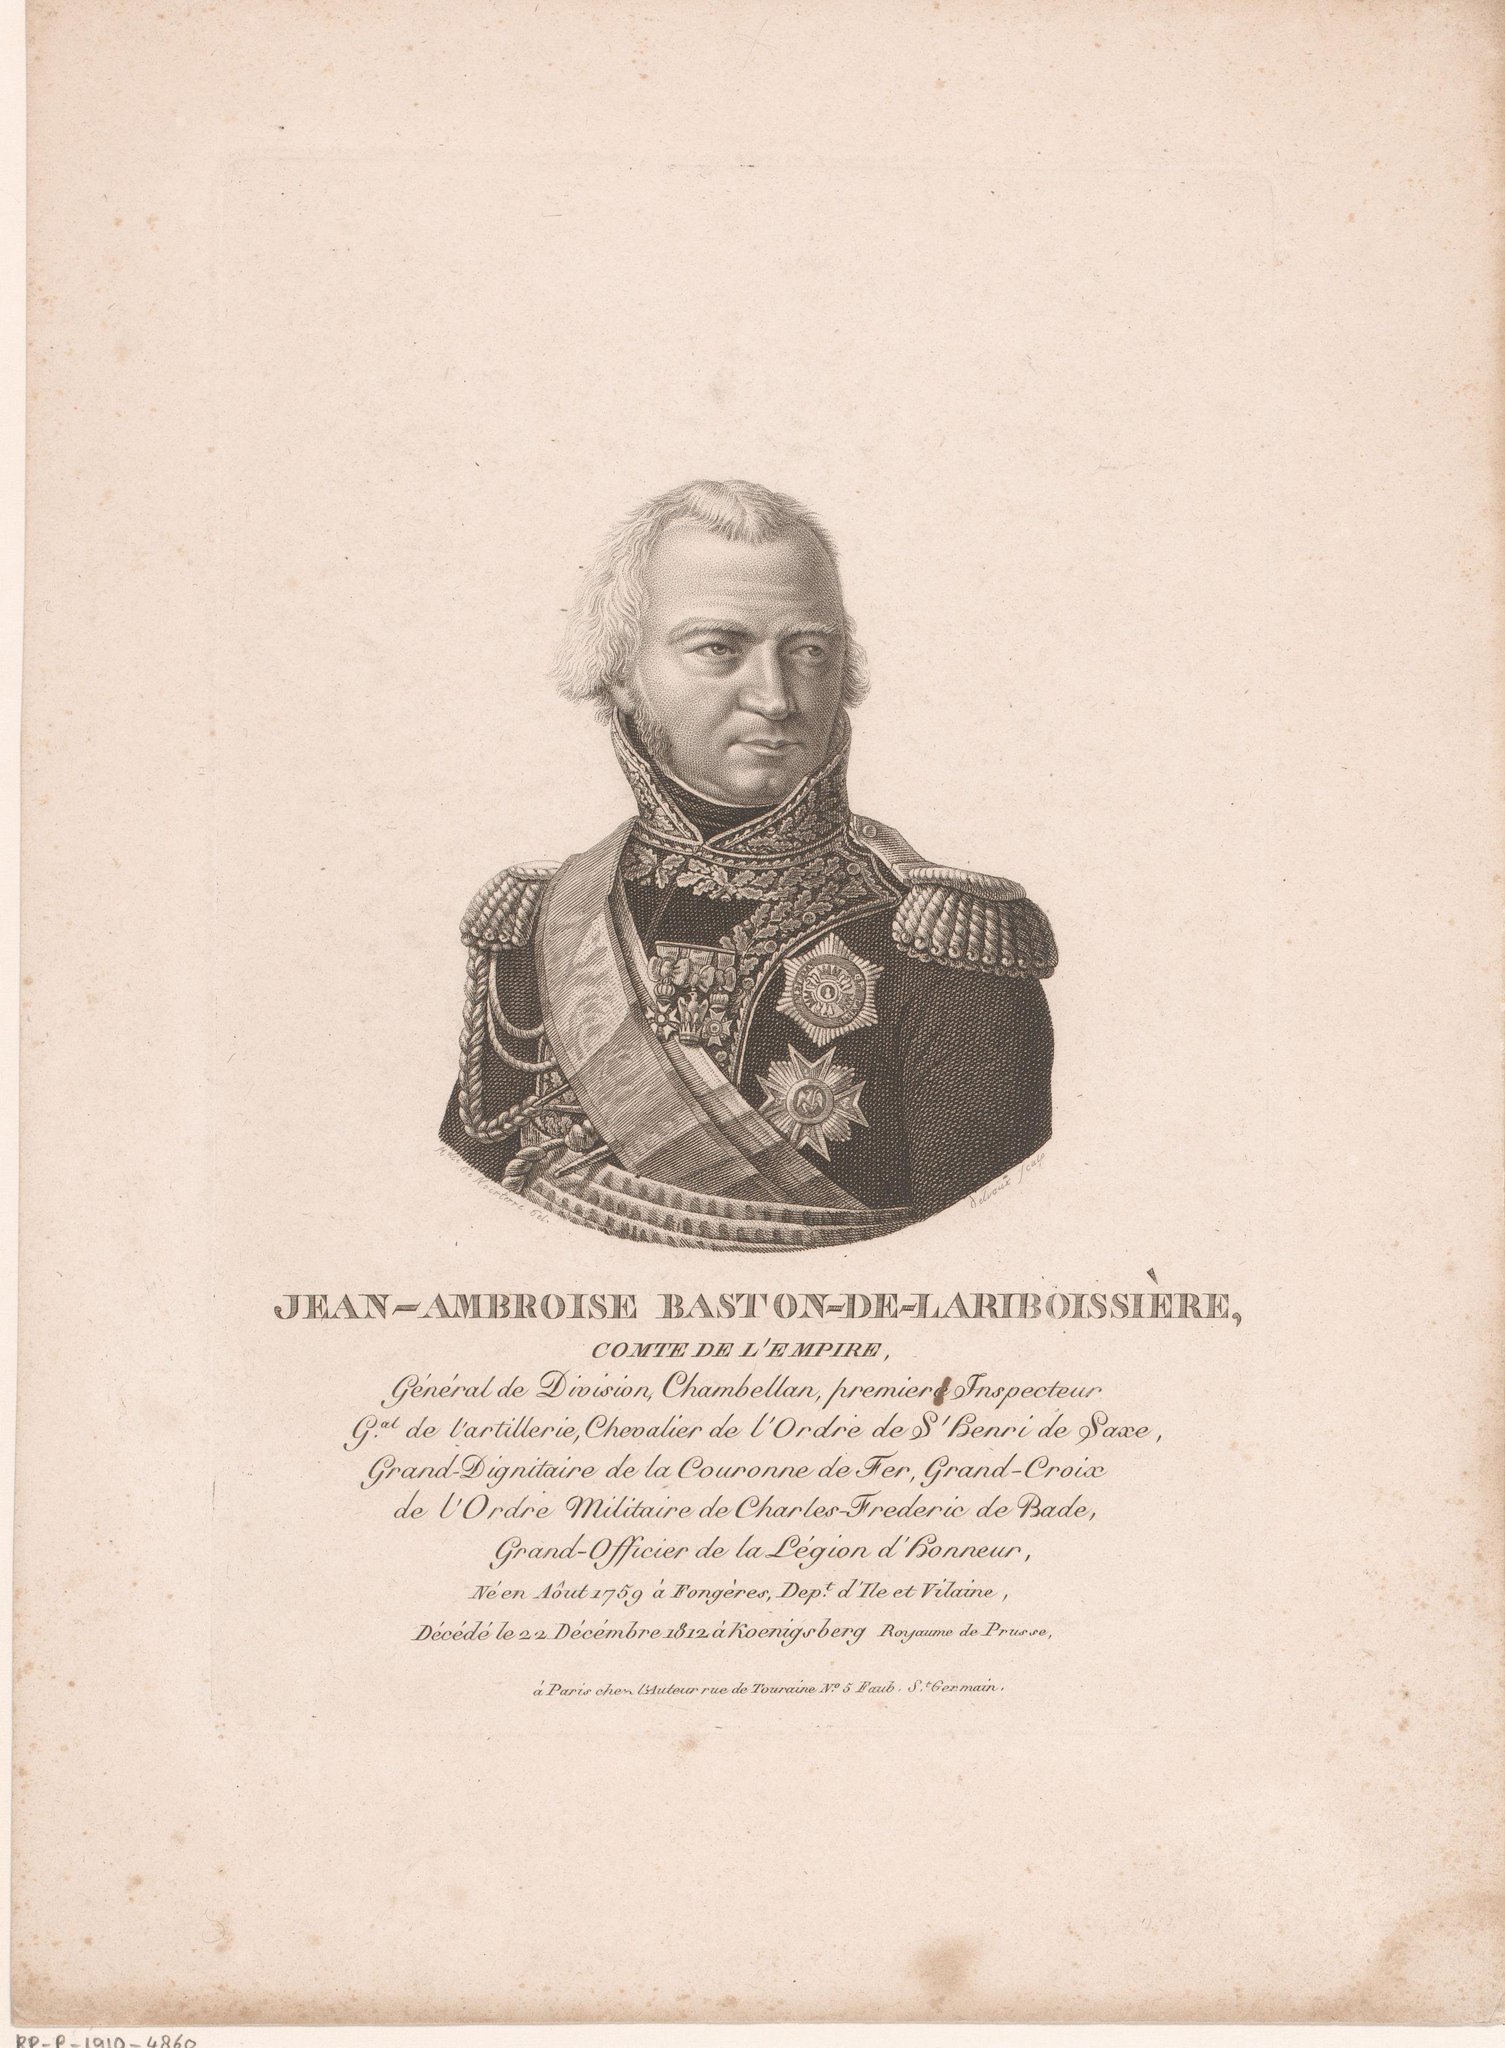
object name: print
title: Portret van Jean Ambroise Baston de Lariboisière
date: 1760-1823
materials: paper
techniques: etching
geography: france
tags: historical persons, decorations, honours (as symbols of the state, etc.)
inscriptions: collector's mark: Lugt 2228